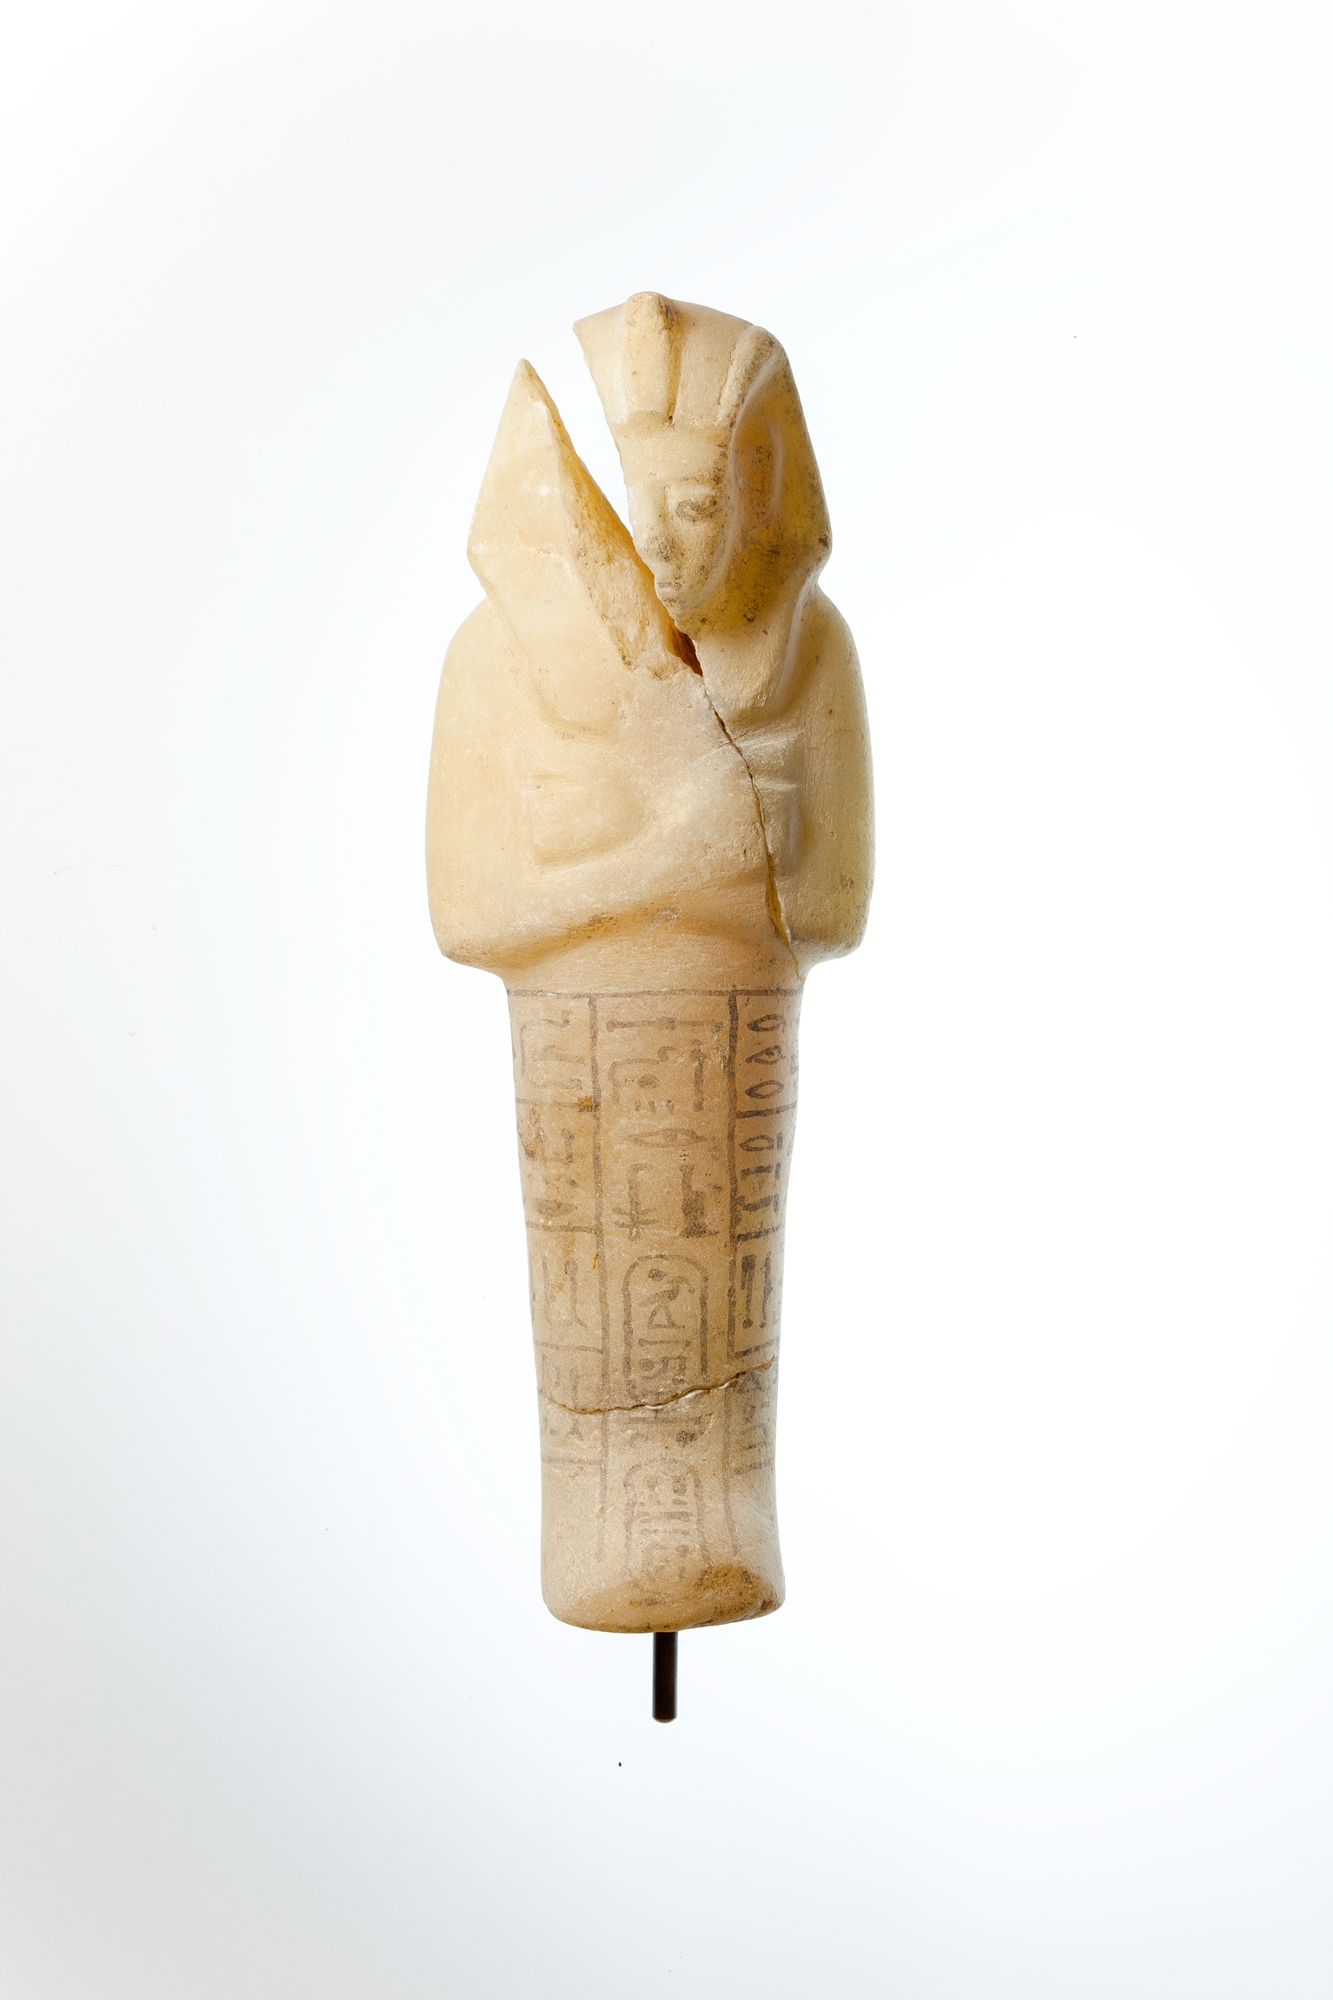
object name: shabti, siptah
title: Shabti of Siptah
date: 1194-1188 BCE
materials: stone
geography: egypt